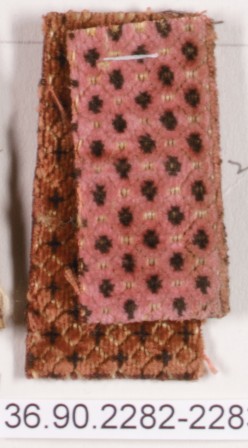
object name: piece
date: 1801-1900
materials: silk